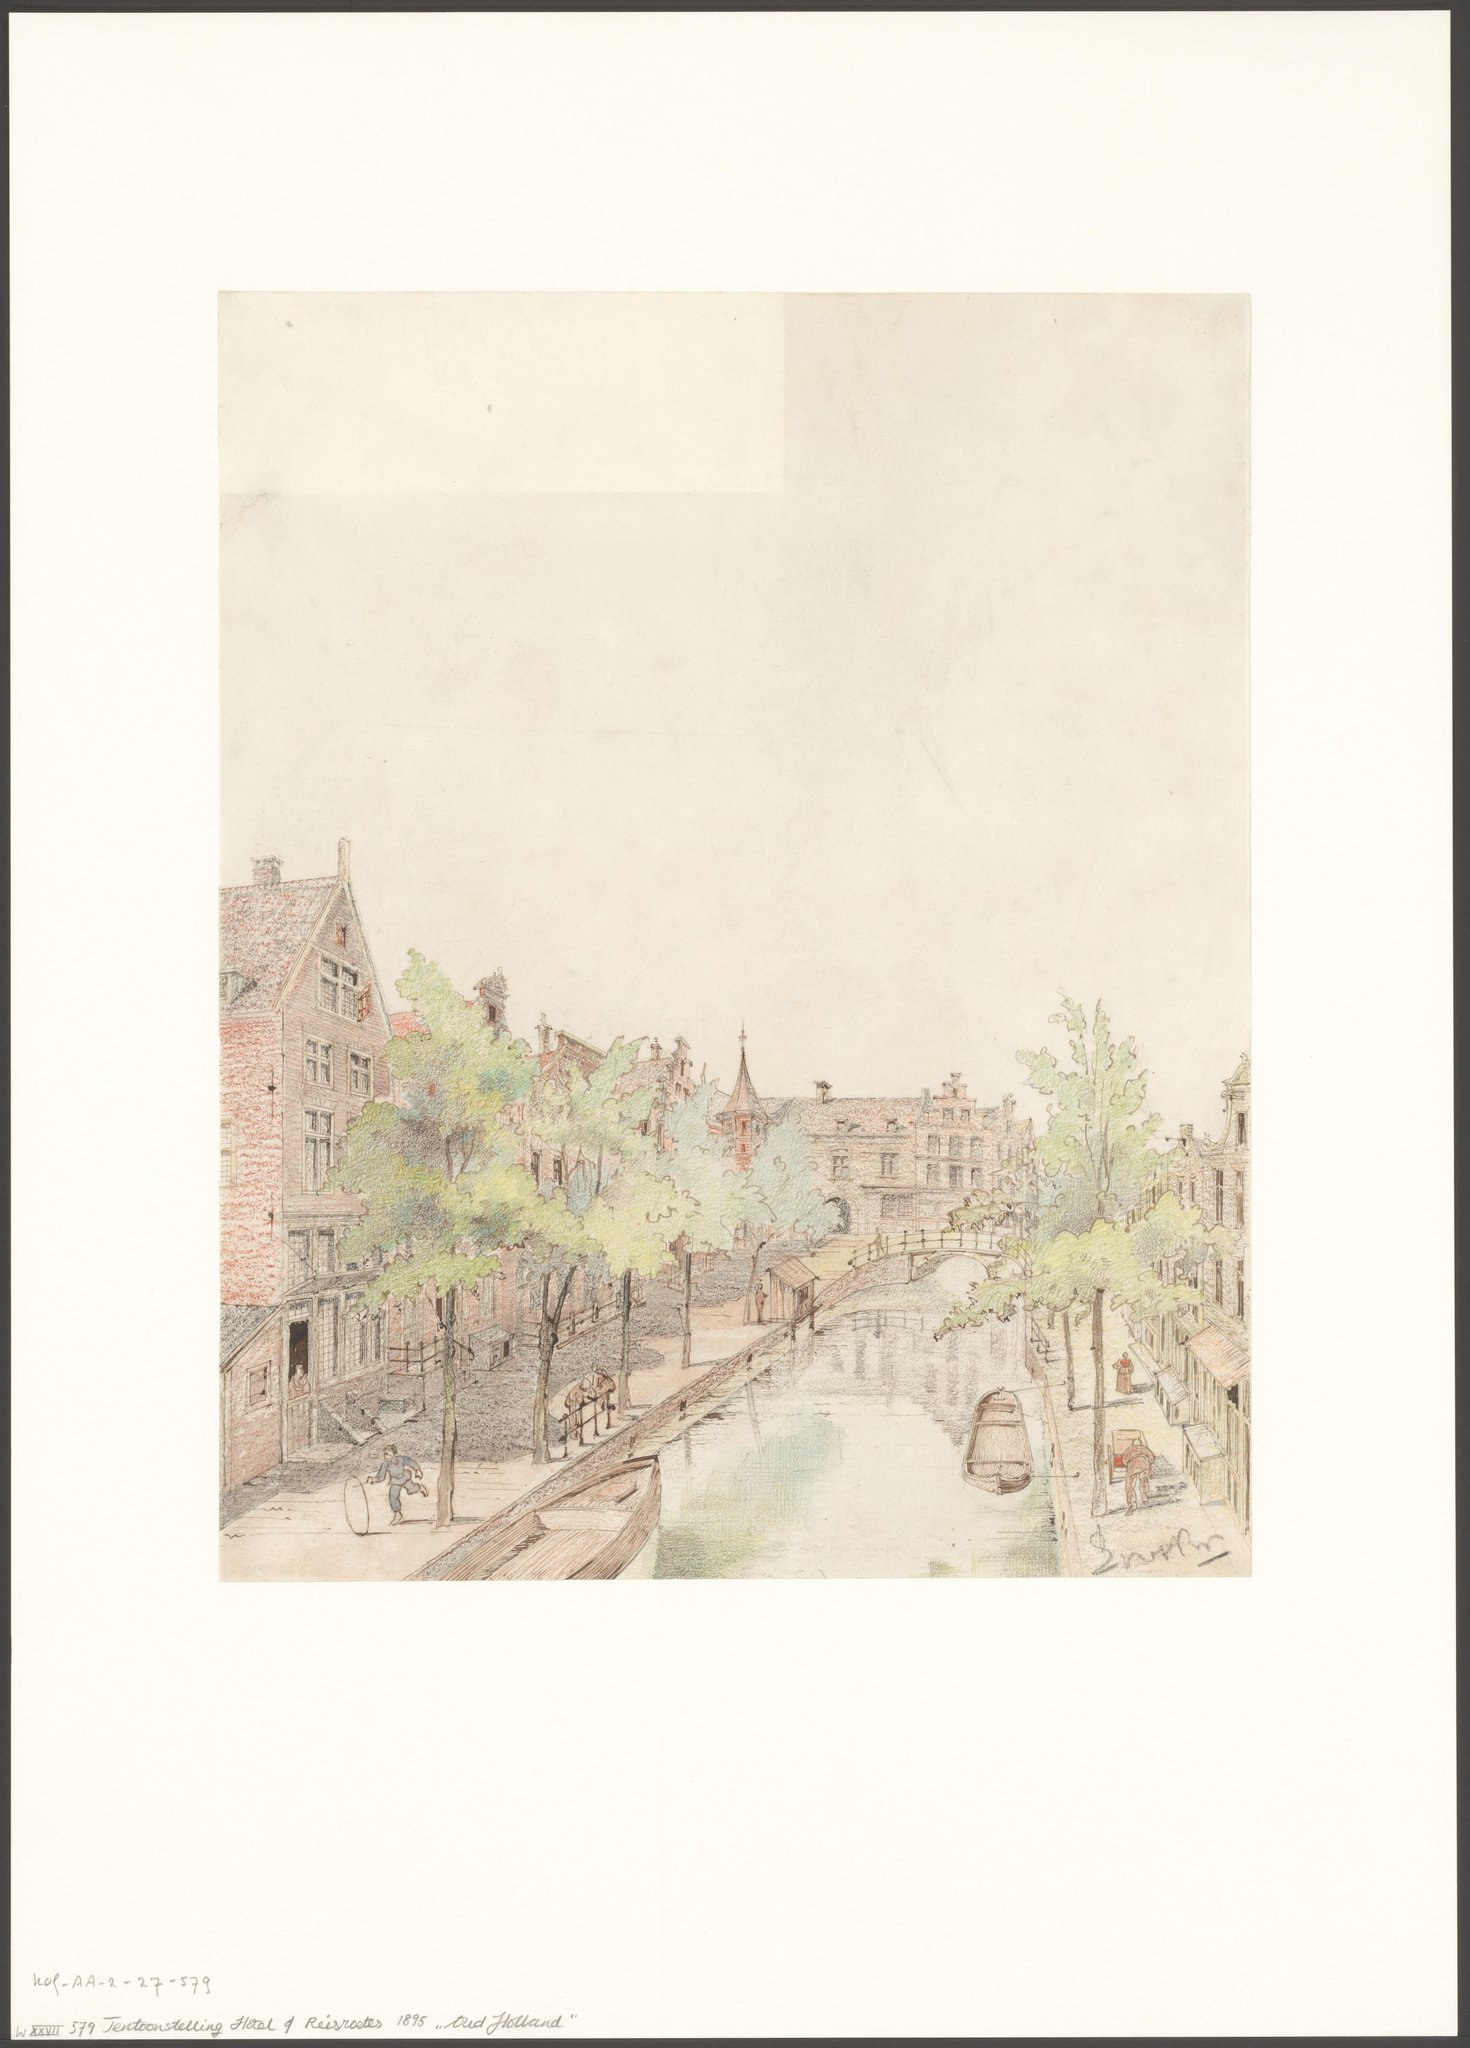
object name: drawing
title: Ontwerp voor Oud Holland, onderdeel van de Wereldtentoonstelling voor het Hotel- en Reiswezen 1895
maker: evert breman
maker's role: architect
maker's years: 1859-1926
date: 1894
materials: chalk, ink, paper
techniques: pen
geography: amsterdam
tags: city-view in general; 'veduta', world fair, world exhibition, village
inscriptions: collector's mark: Lugt 800a, signature: ‘EBreman’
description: Tekening binnen de Atlas Van Eck ingedeeld op wijknummer 27.